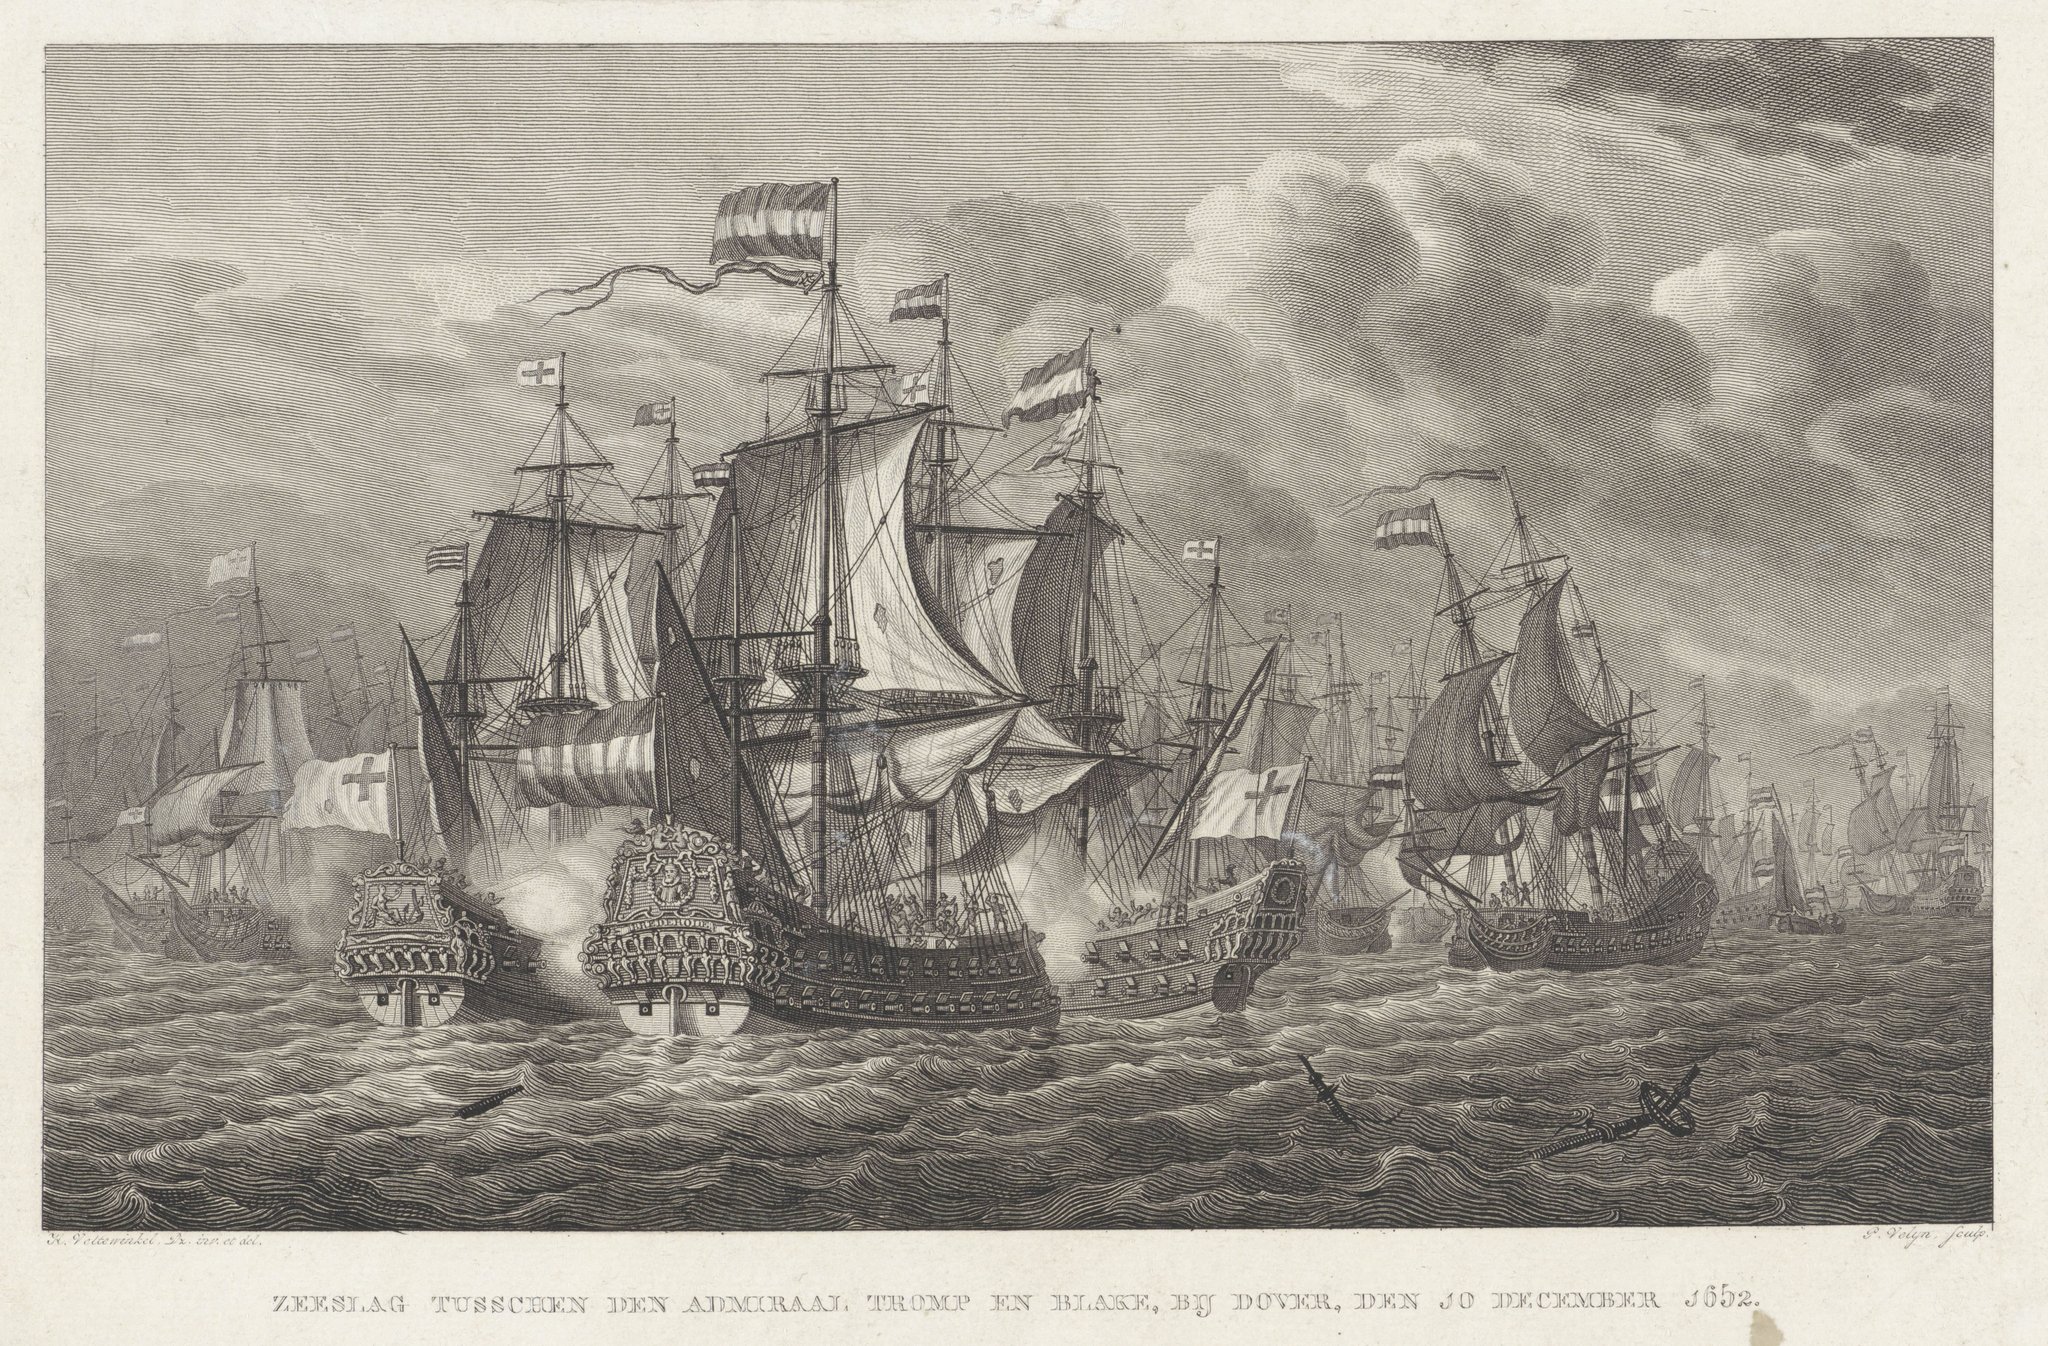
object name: print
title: Zeeslag bij Dungeness, 10 december 1652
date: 1797-1836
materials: paper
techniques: engraving, etching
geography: netherlands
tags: brielle, maarten harpertszoon tromp, battle (+ sailing-ships), battle of dungeness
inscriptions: collector's mark: Lugt 2228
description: Zeegezicht met zeilschepen, voorstellende de zeeslag bij Dungeness op 10 december 1652.